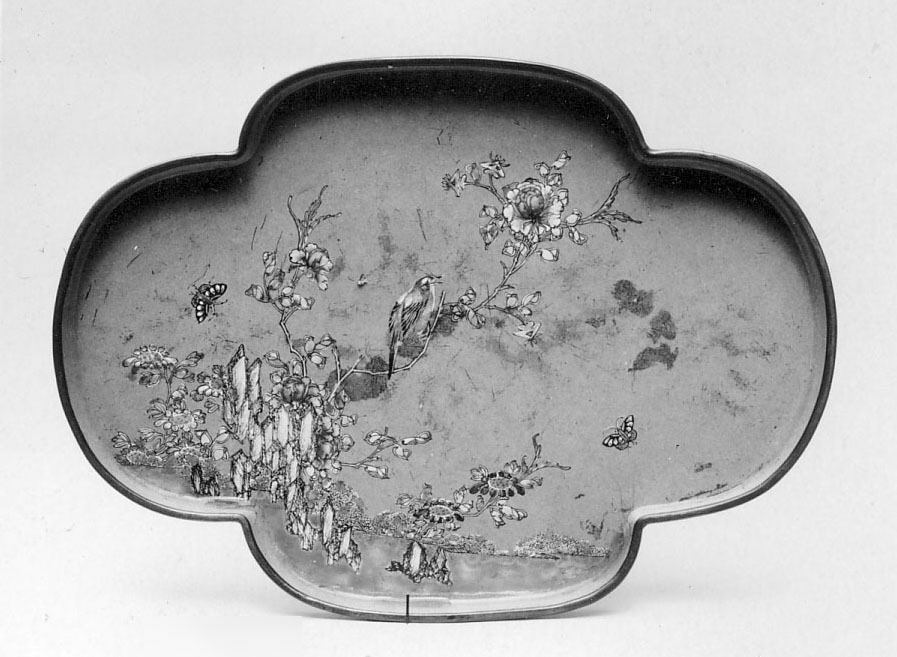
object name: tray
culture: chinese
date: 1736-1795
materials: enamel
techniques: painting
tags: birds,butterflies,flowers